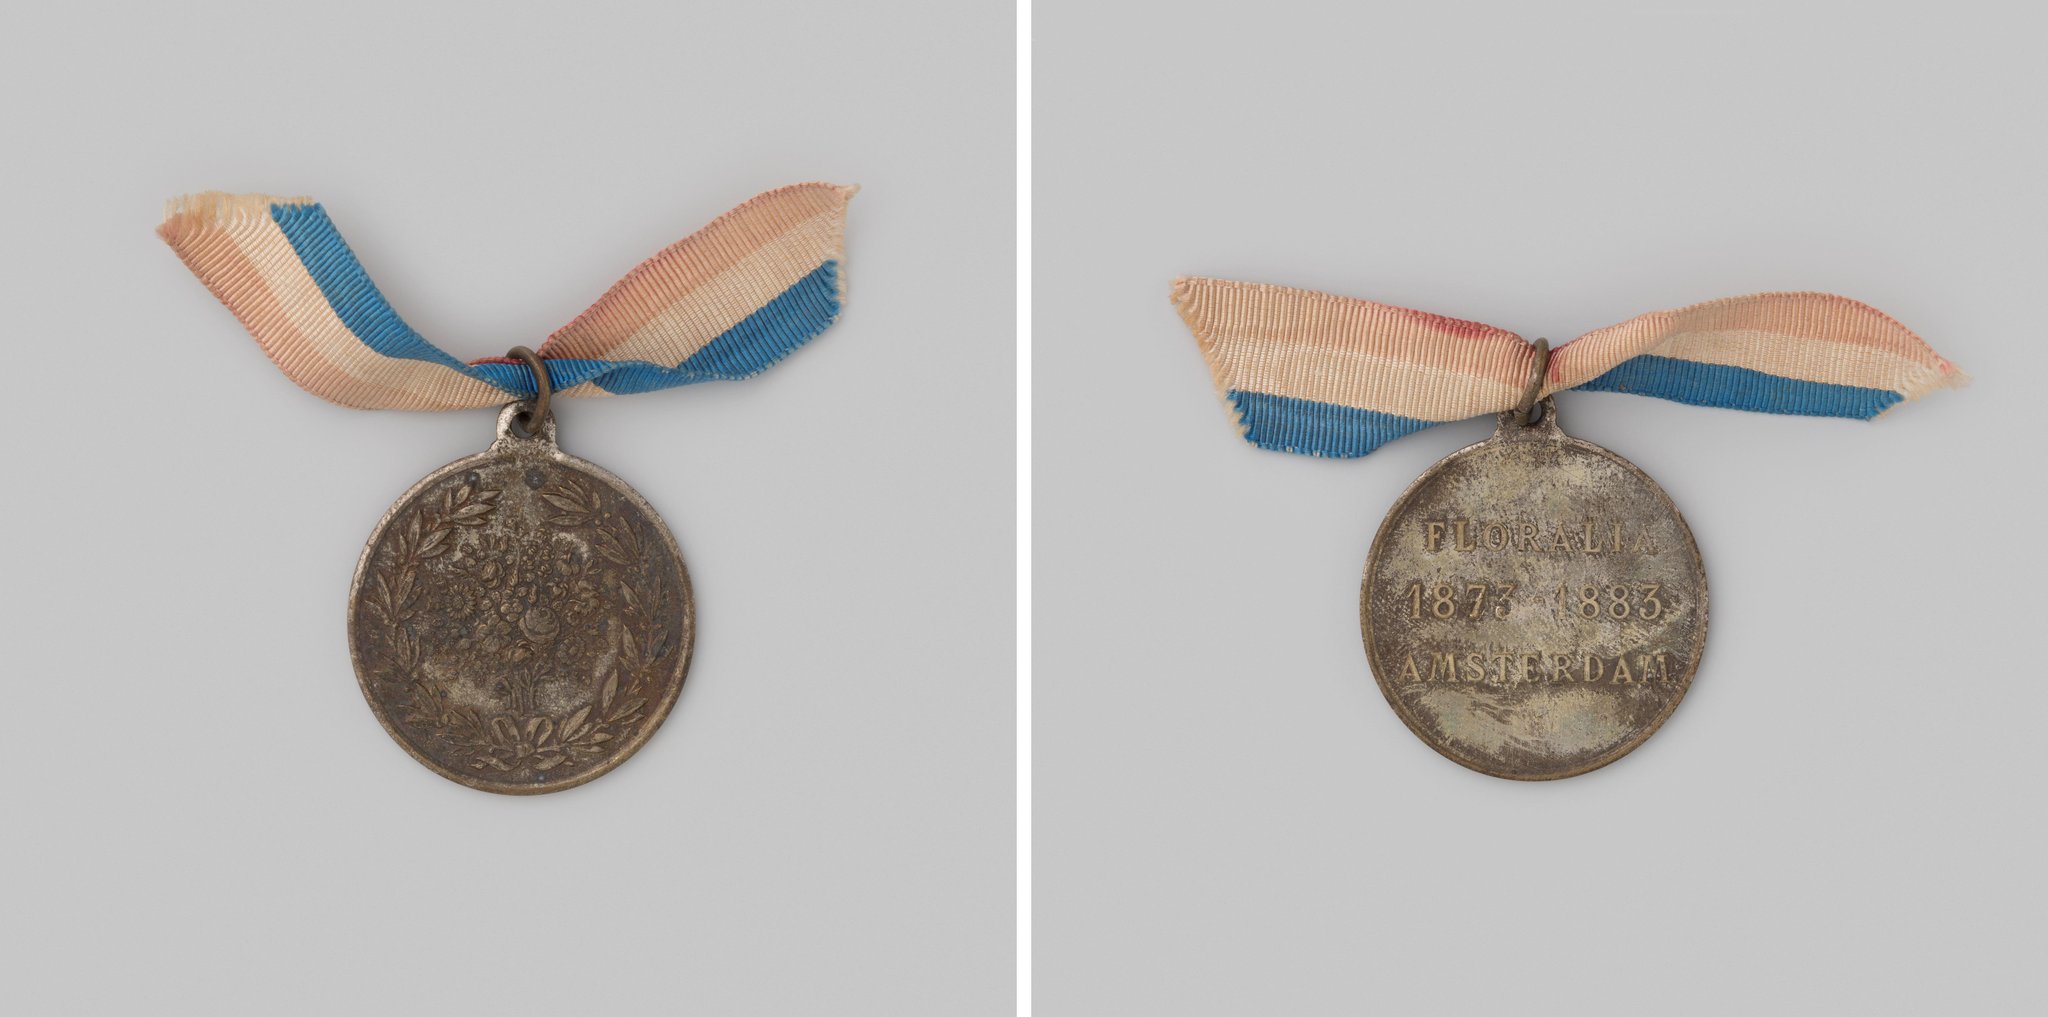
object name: history medal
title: Tienjarig bestaan van Floralia te Amsterdam 1883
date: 1883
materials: brass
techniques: striking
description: Penning met oog en draagring aan rood-wit-blauw lint, op de voorzijde een bos bloemen tussen samengestrikte lauwertakken, op de keerzijde drie regels tekst.